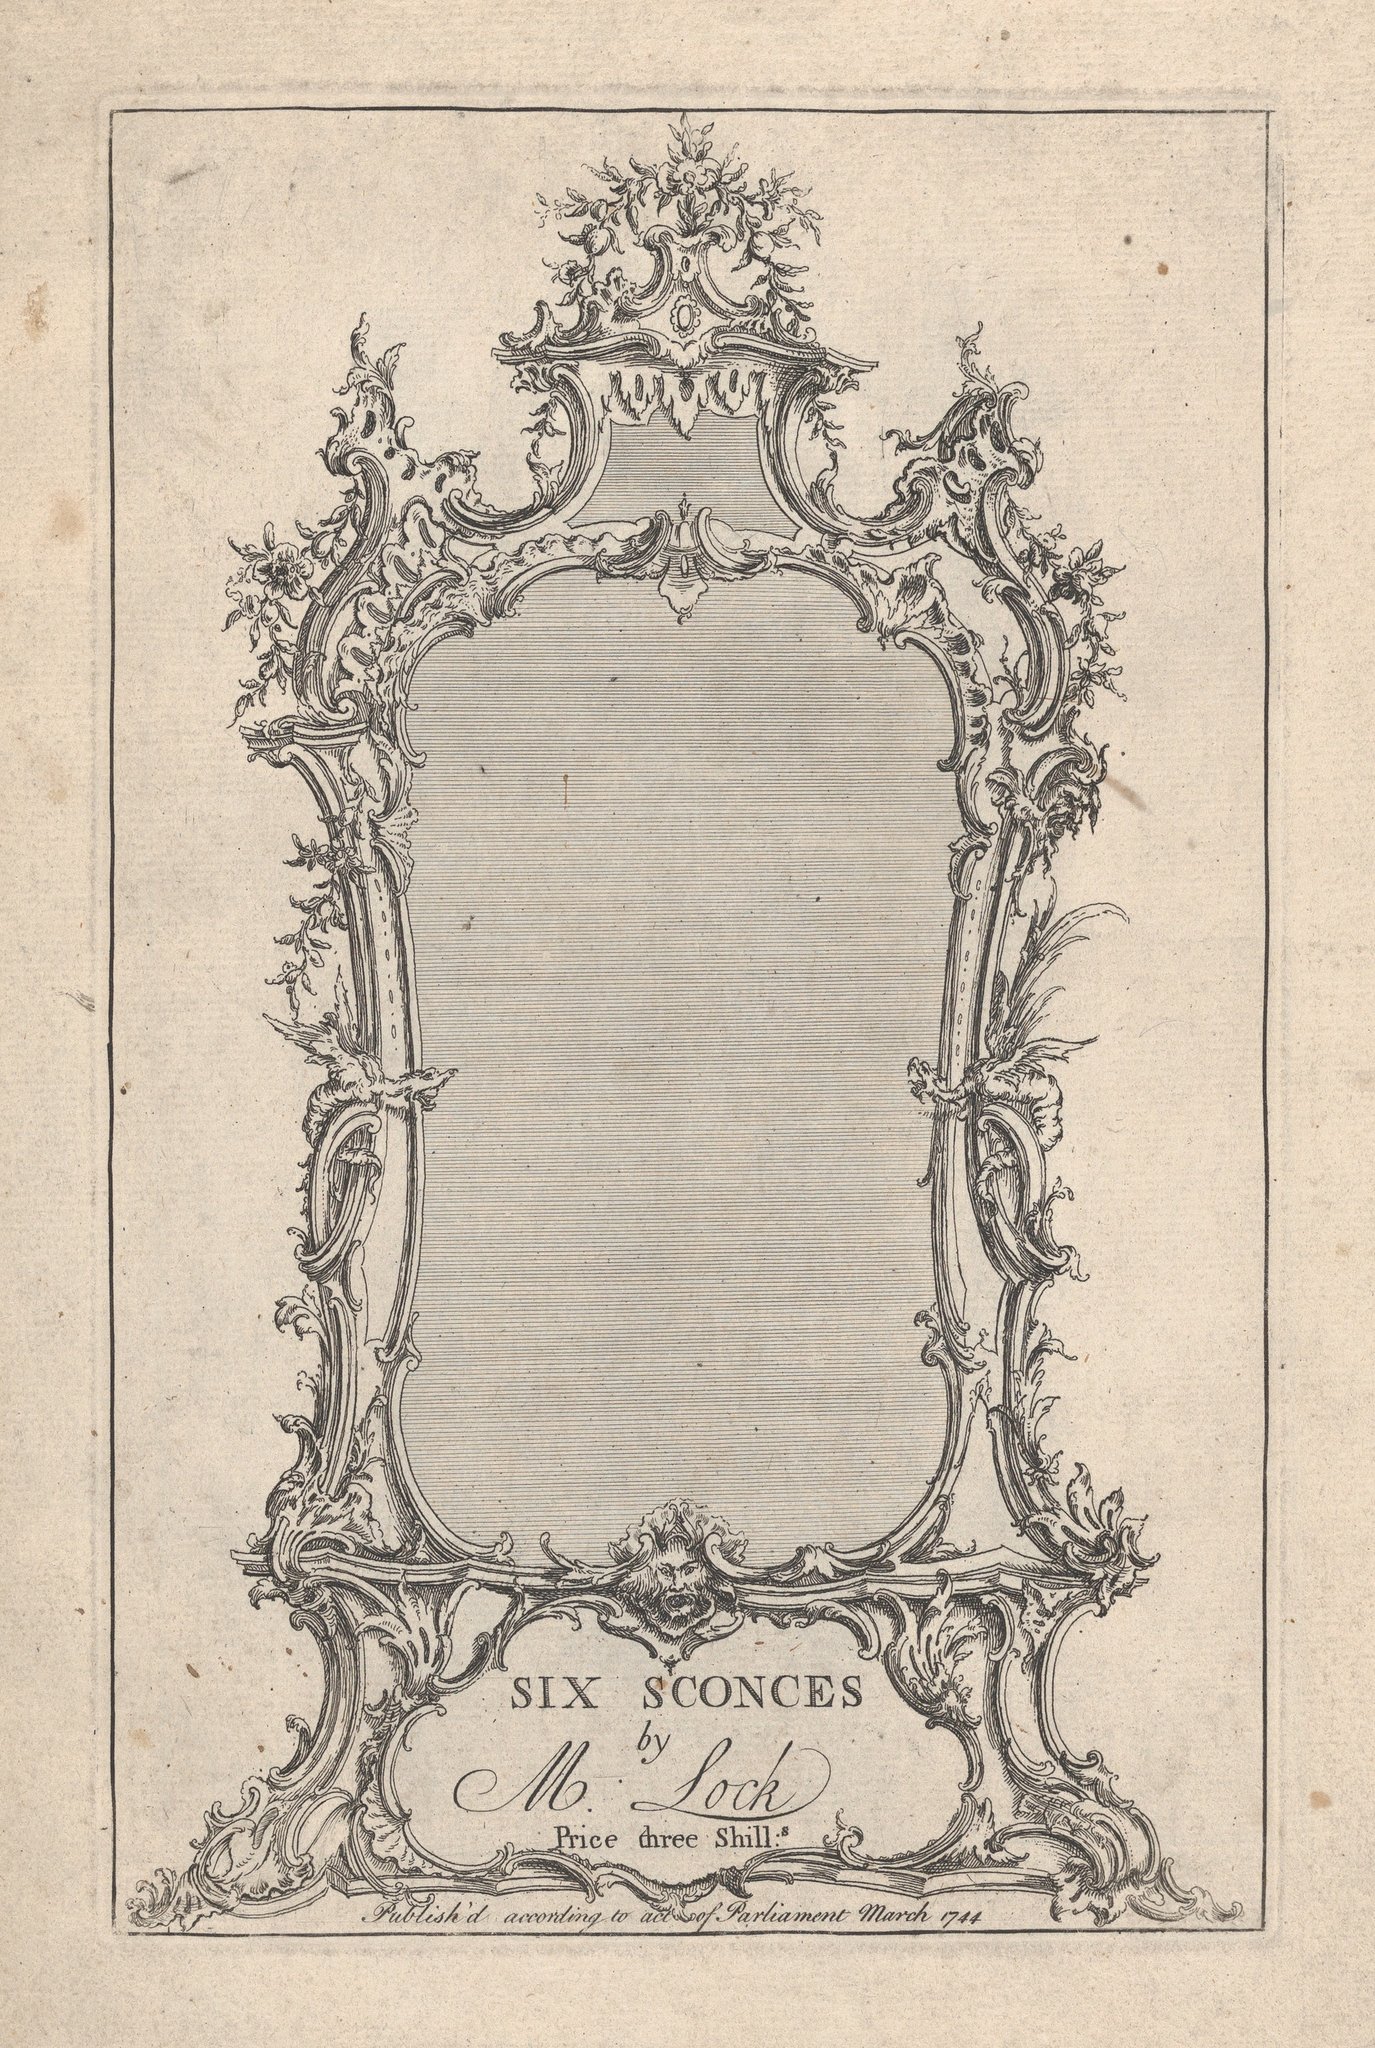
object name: book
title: Six Sconces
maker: matthias lock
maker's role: designer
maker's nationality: british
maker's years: 1705-1760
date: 1744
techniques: etching